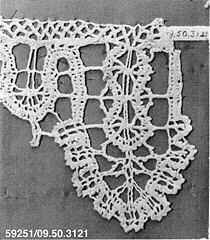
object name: fragment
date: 1601-1700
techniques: lace